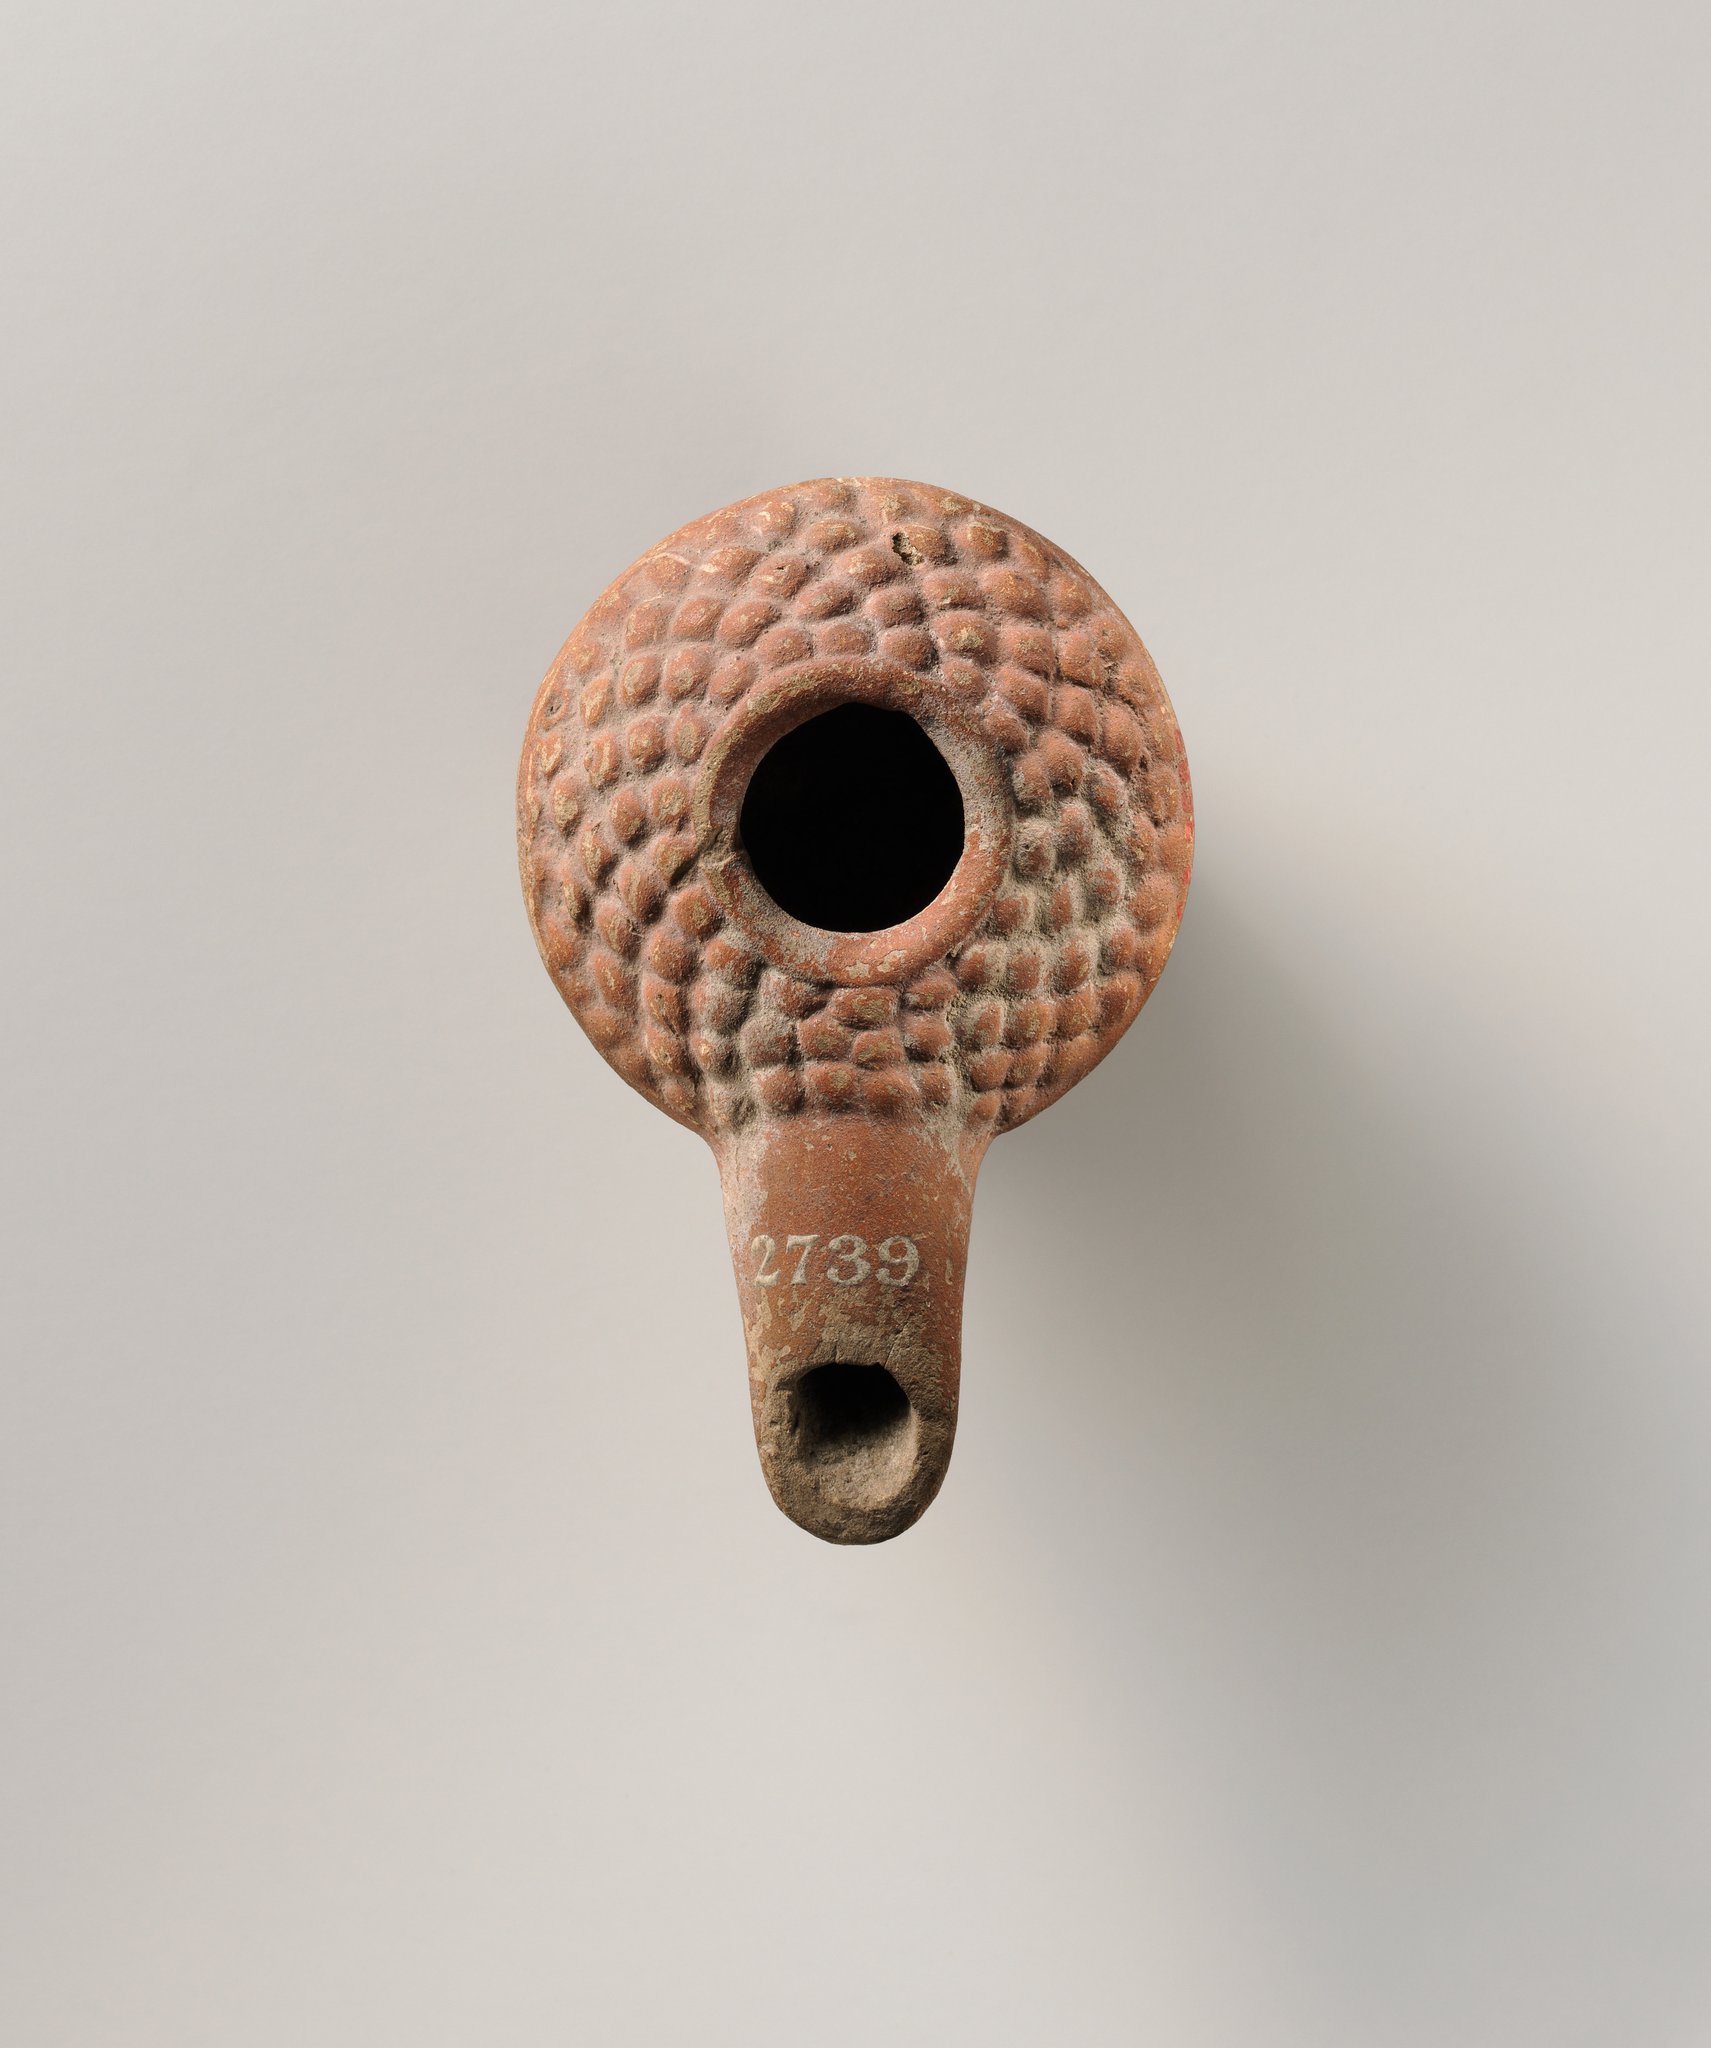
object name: lamp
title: Terracotta oil lamp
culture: greek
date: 234-68 BCE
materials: terracotta